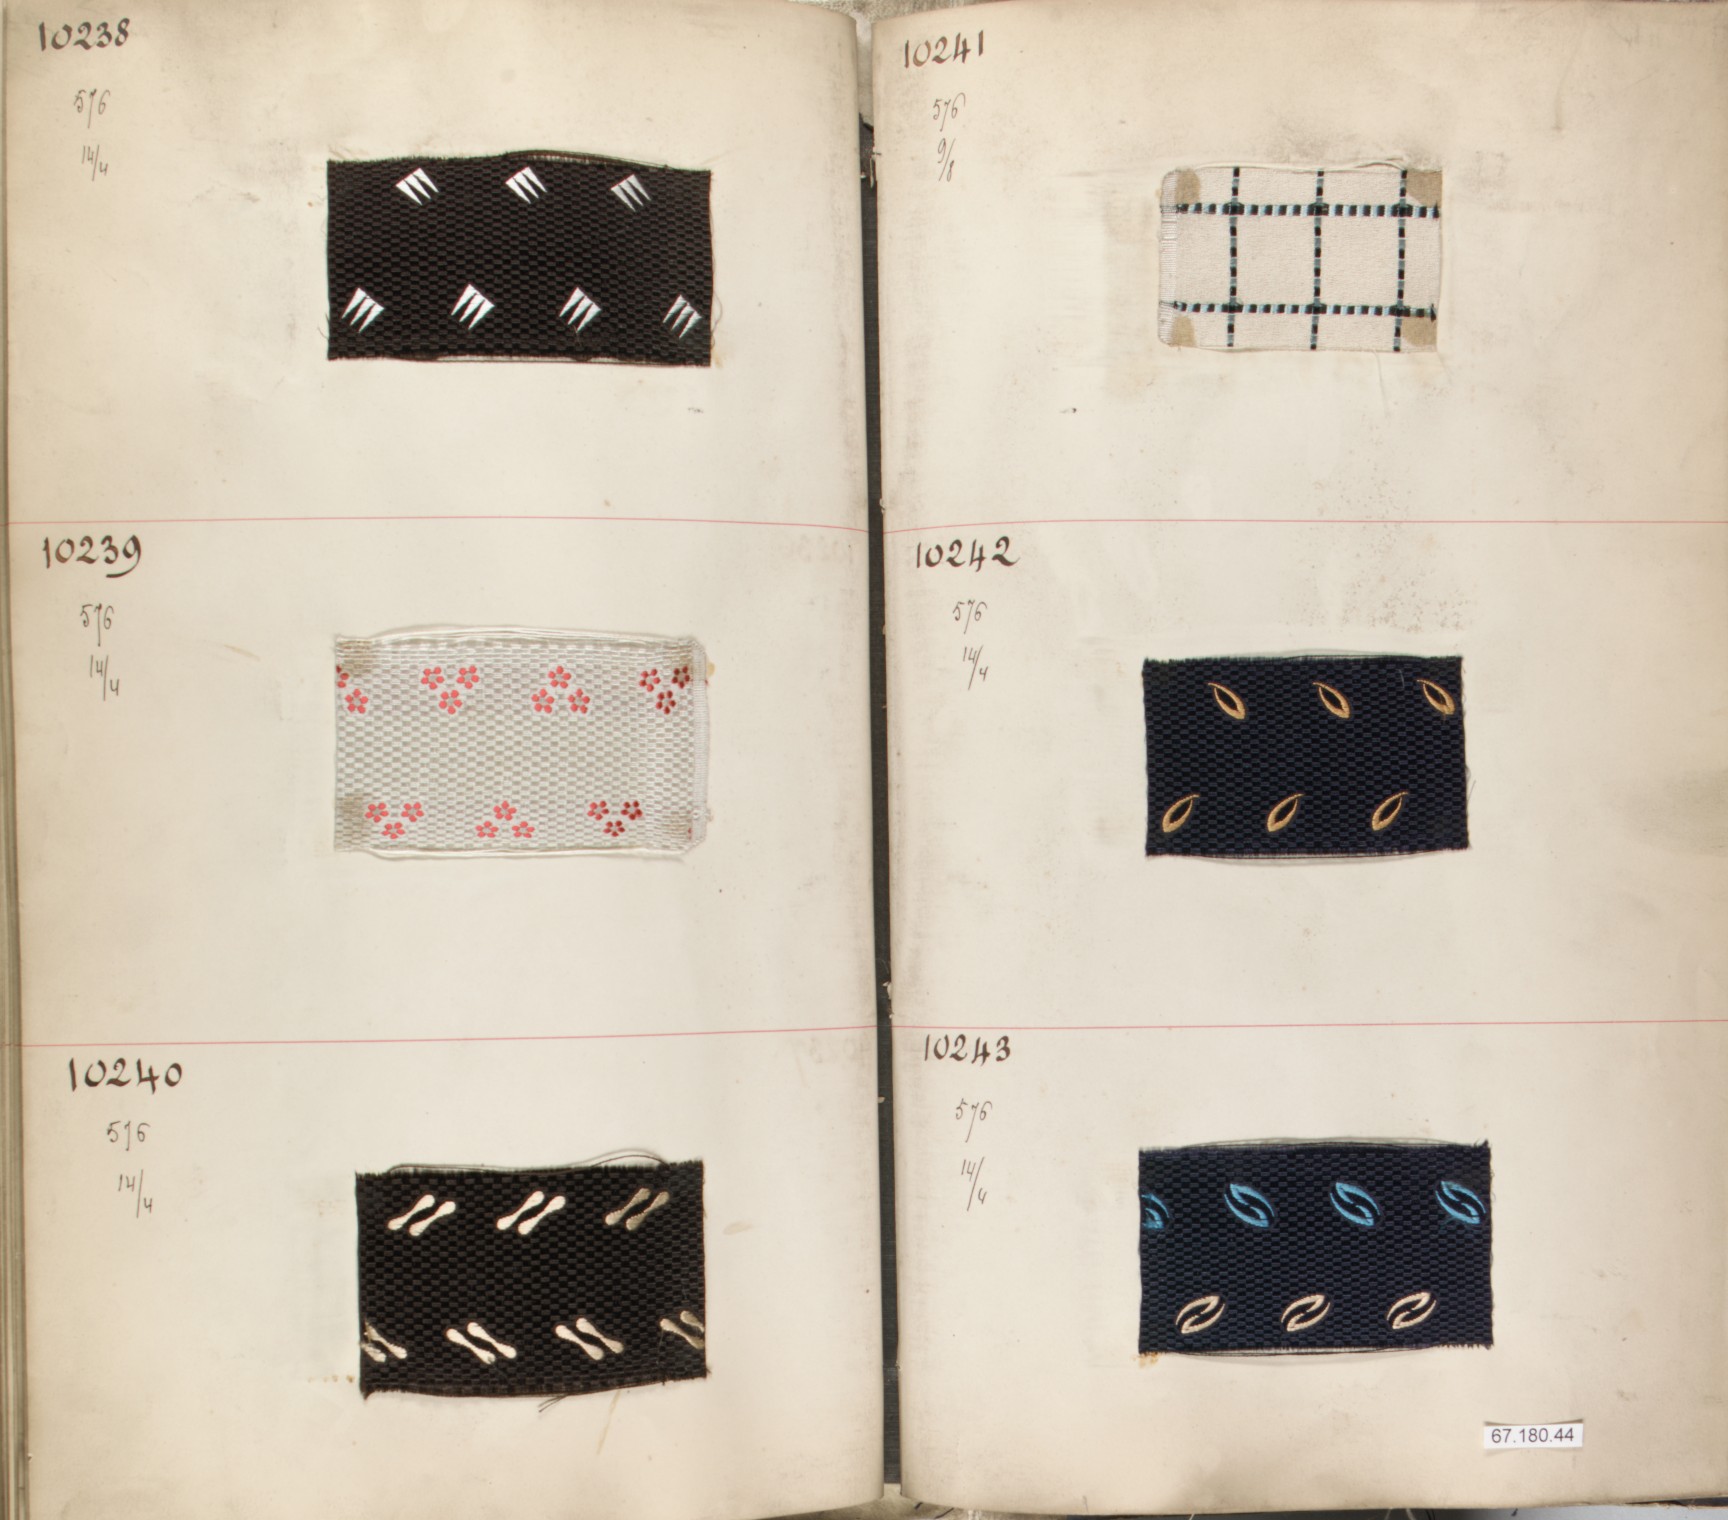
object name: sample book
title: Textile Sample Book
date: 1881